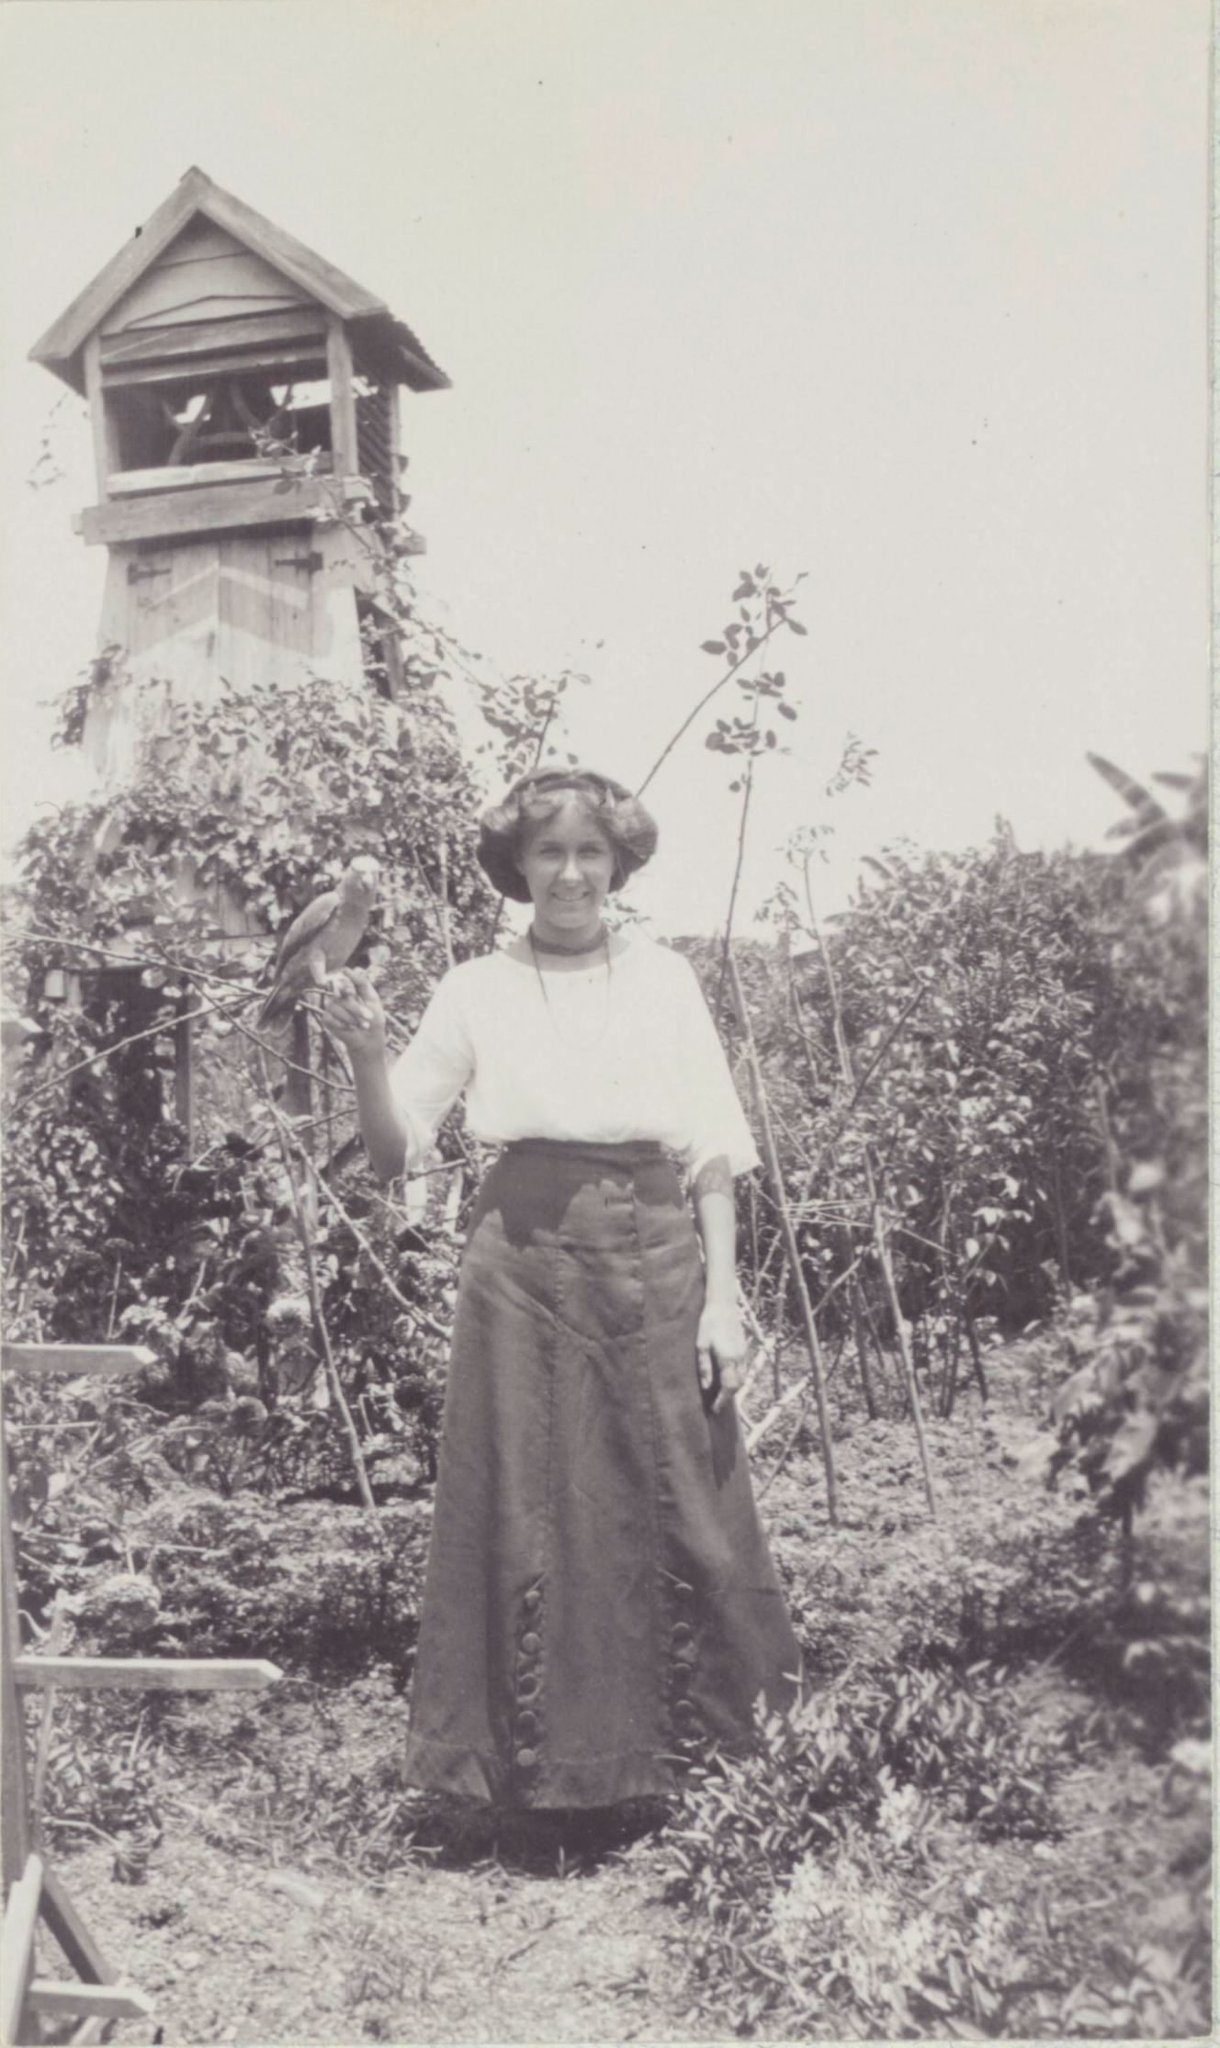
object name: photograph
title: Maria Gonggrijp met papegaai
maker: andries augustus boom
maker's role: amateurfotograaf, handelaar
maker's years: 1878-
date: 1911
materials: photographic support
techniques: photography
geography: suriname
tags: ornamental birds: parrot, suriname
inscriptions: inscription: ‘Clevia 1911’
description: Maria Gonggrijp staande voor een toren in de tuin op Plantage Clevia 1911. Op haar hand zit een papegaai of een parkiet. Onderdeel van het fotoalbum van de familie Boom-Gonggrijp in Suriname en Curaçao.